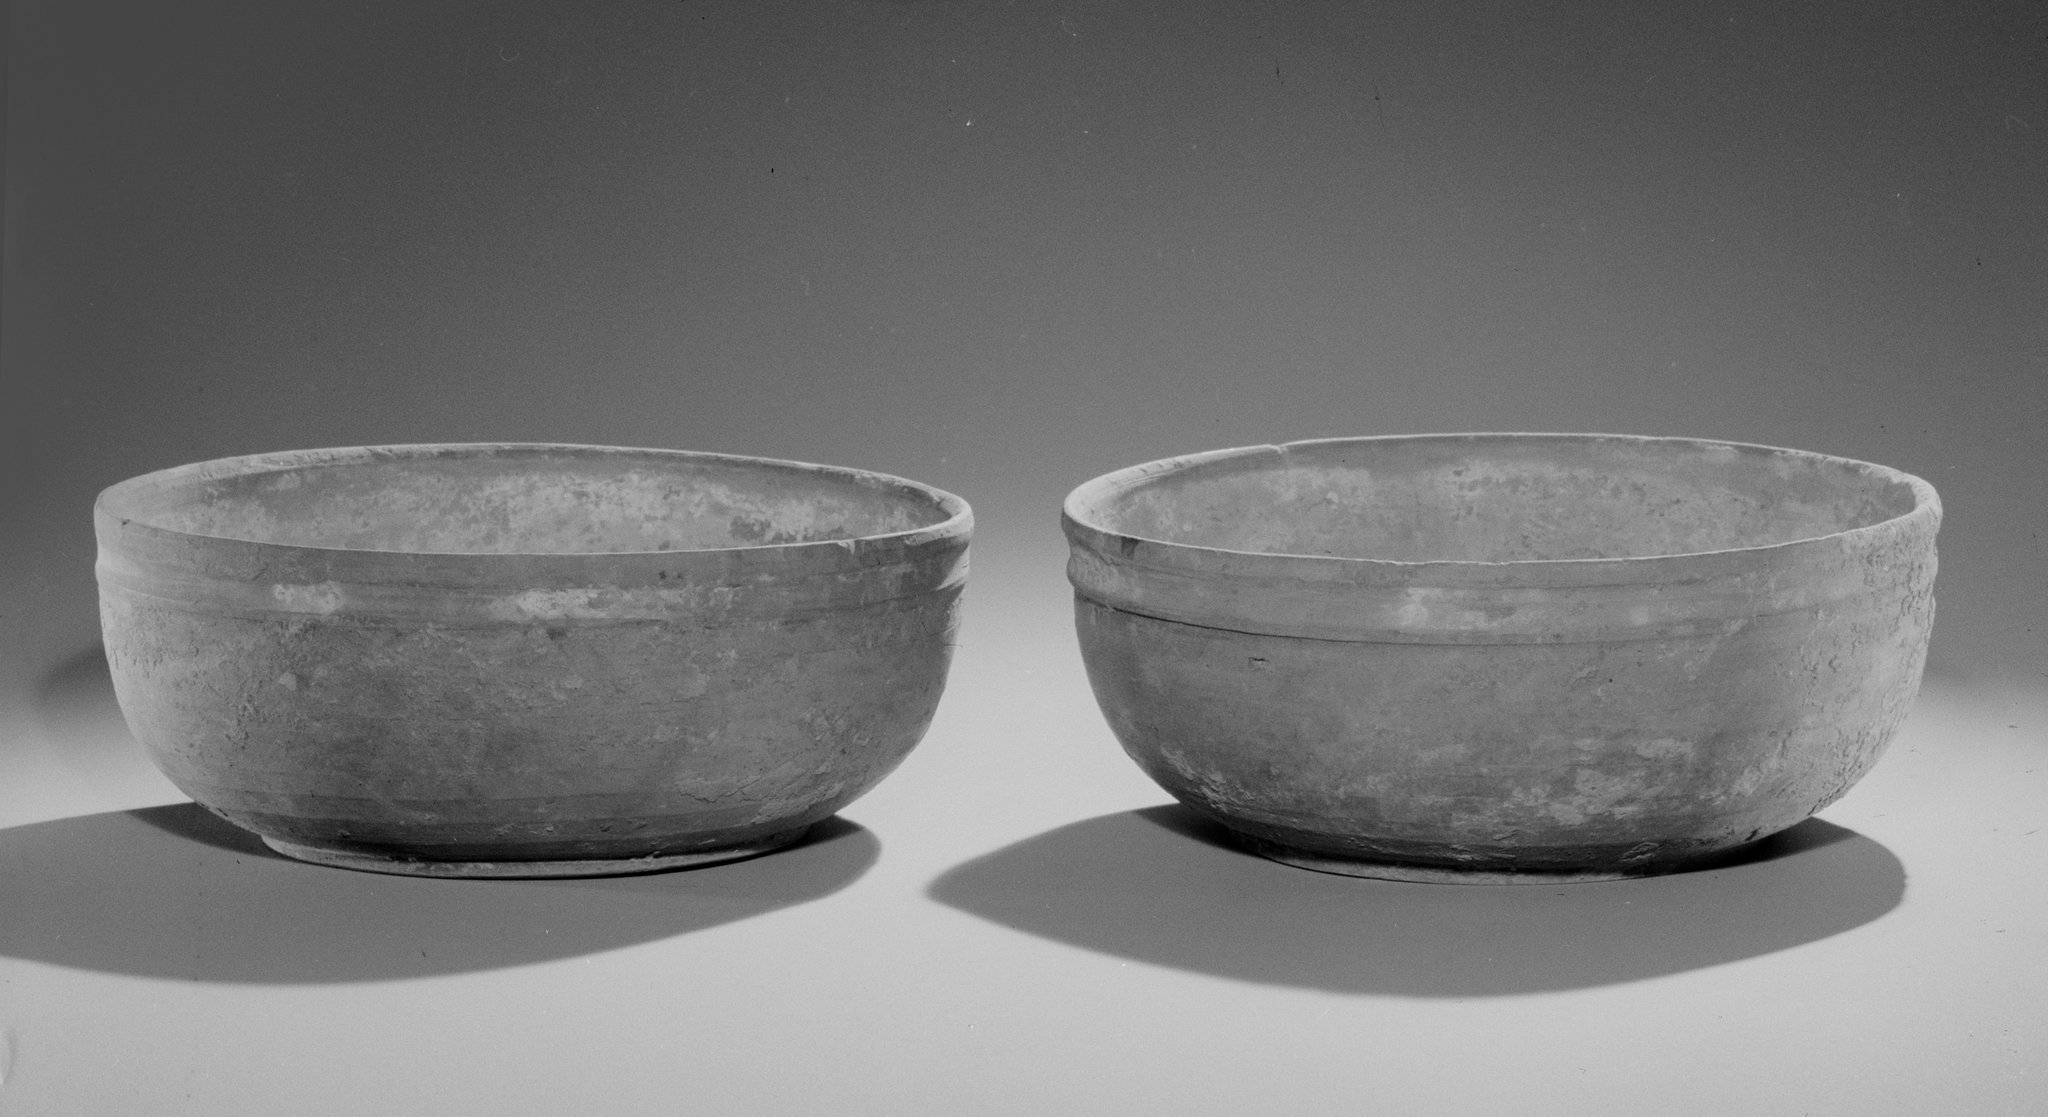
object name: bowl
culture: chinese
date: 618-907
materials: earthenware